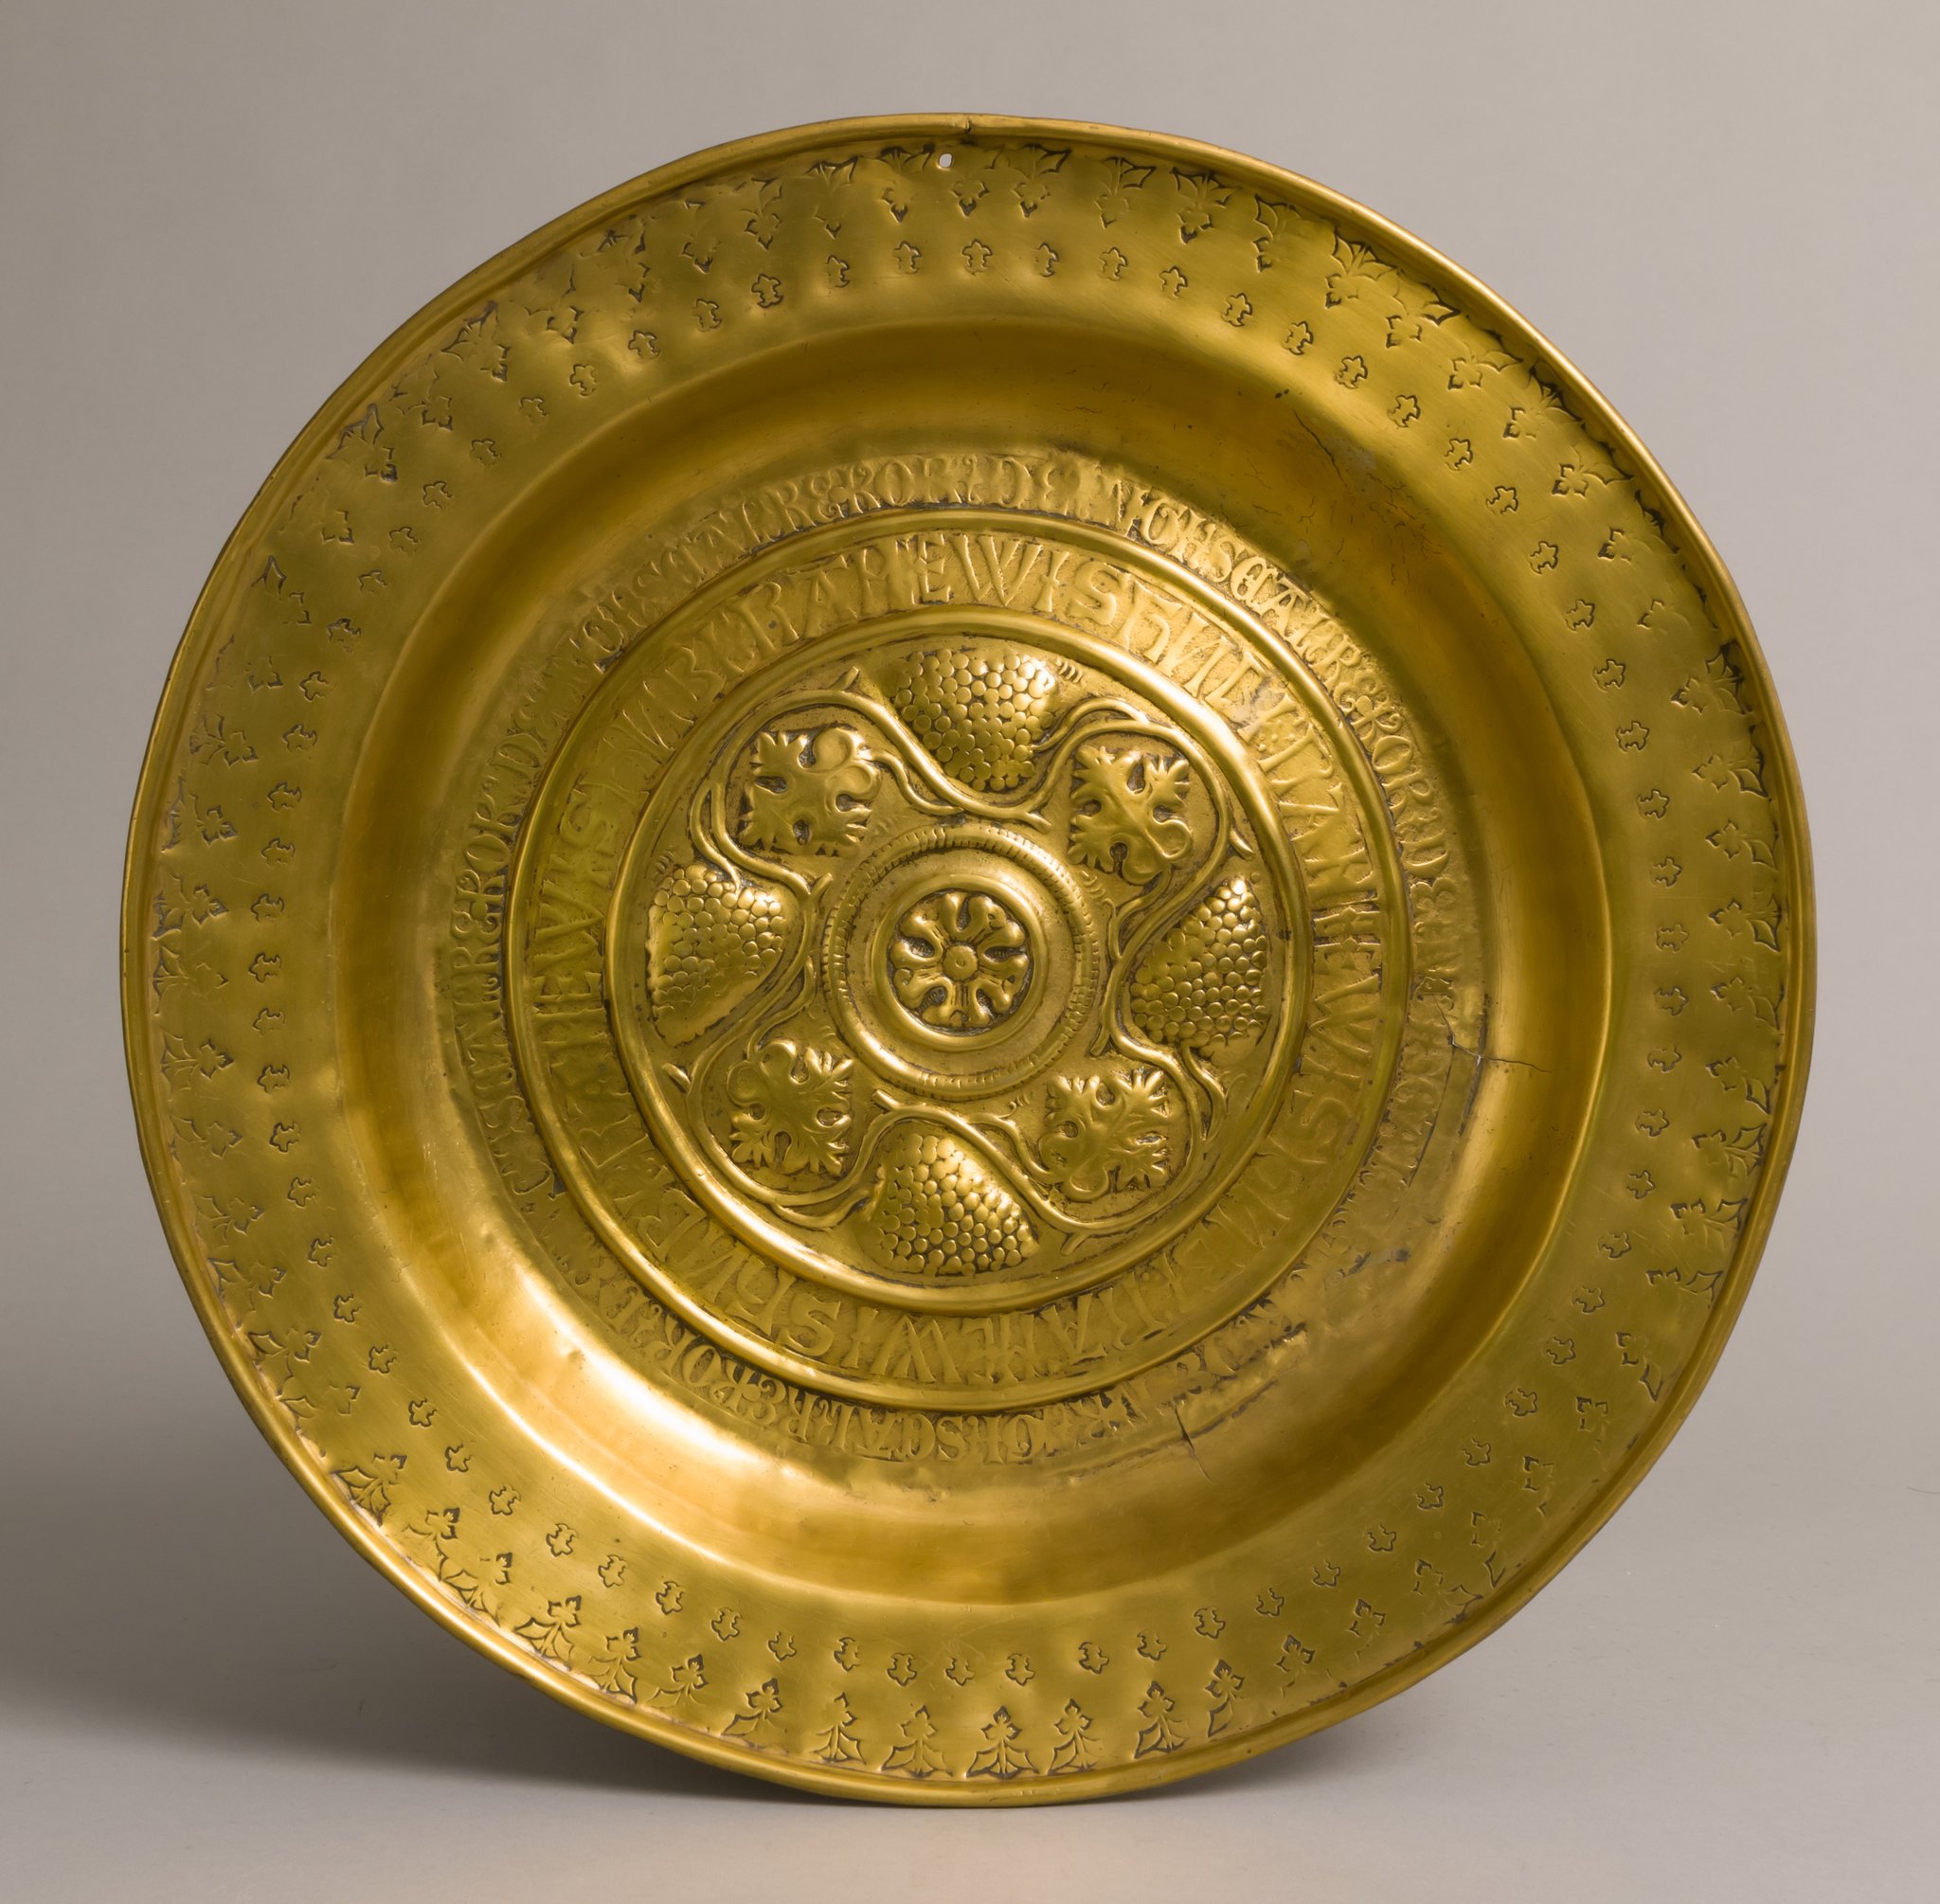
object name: dish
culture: german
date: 1501-1533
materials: brass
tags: grapes